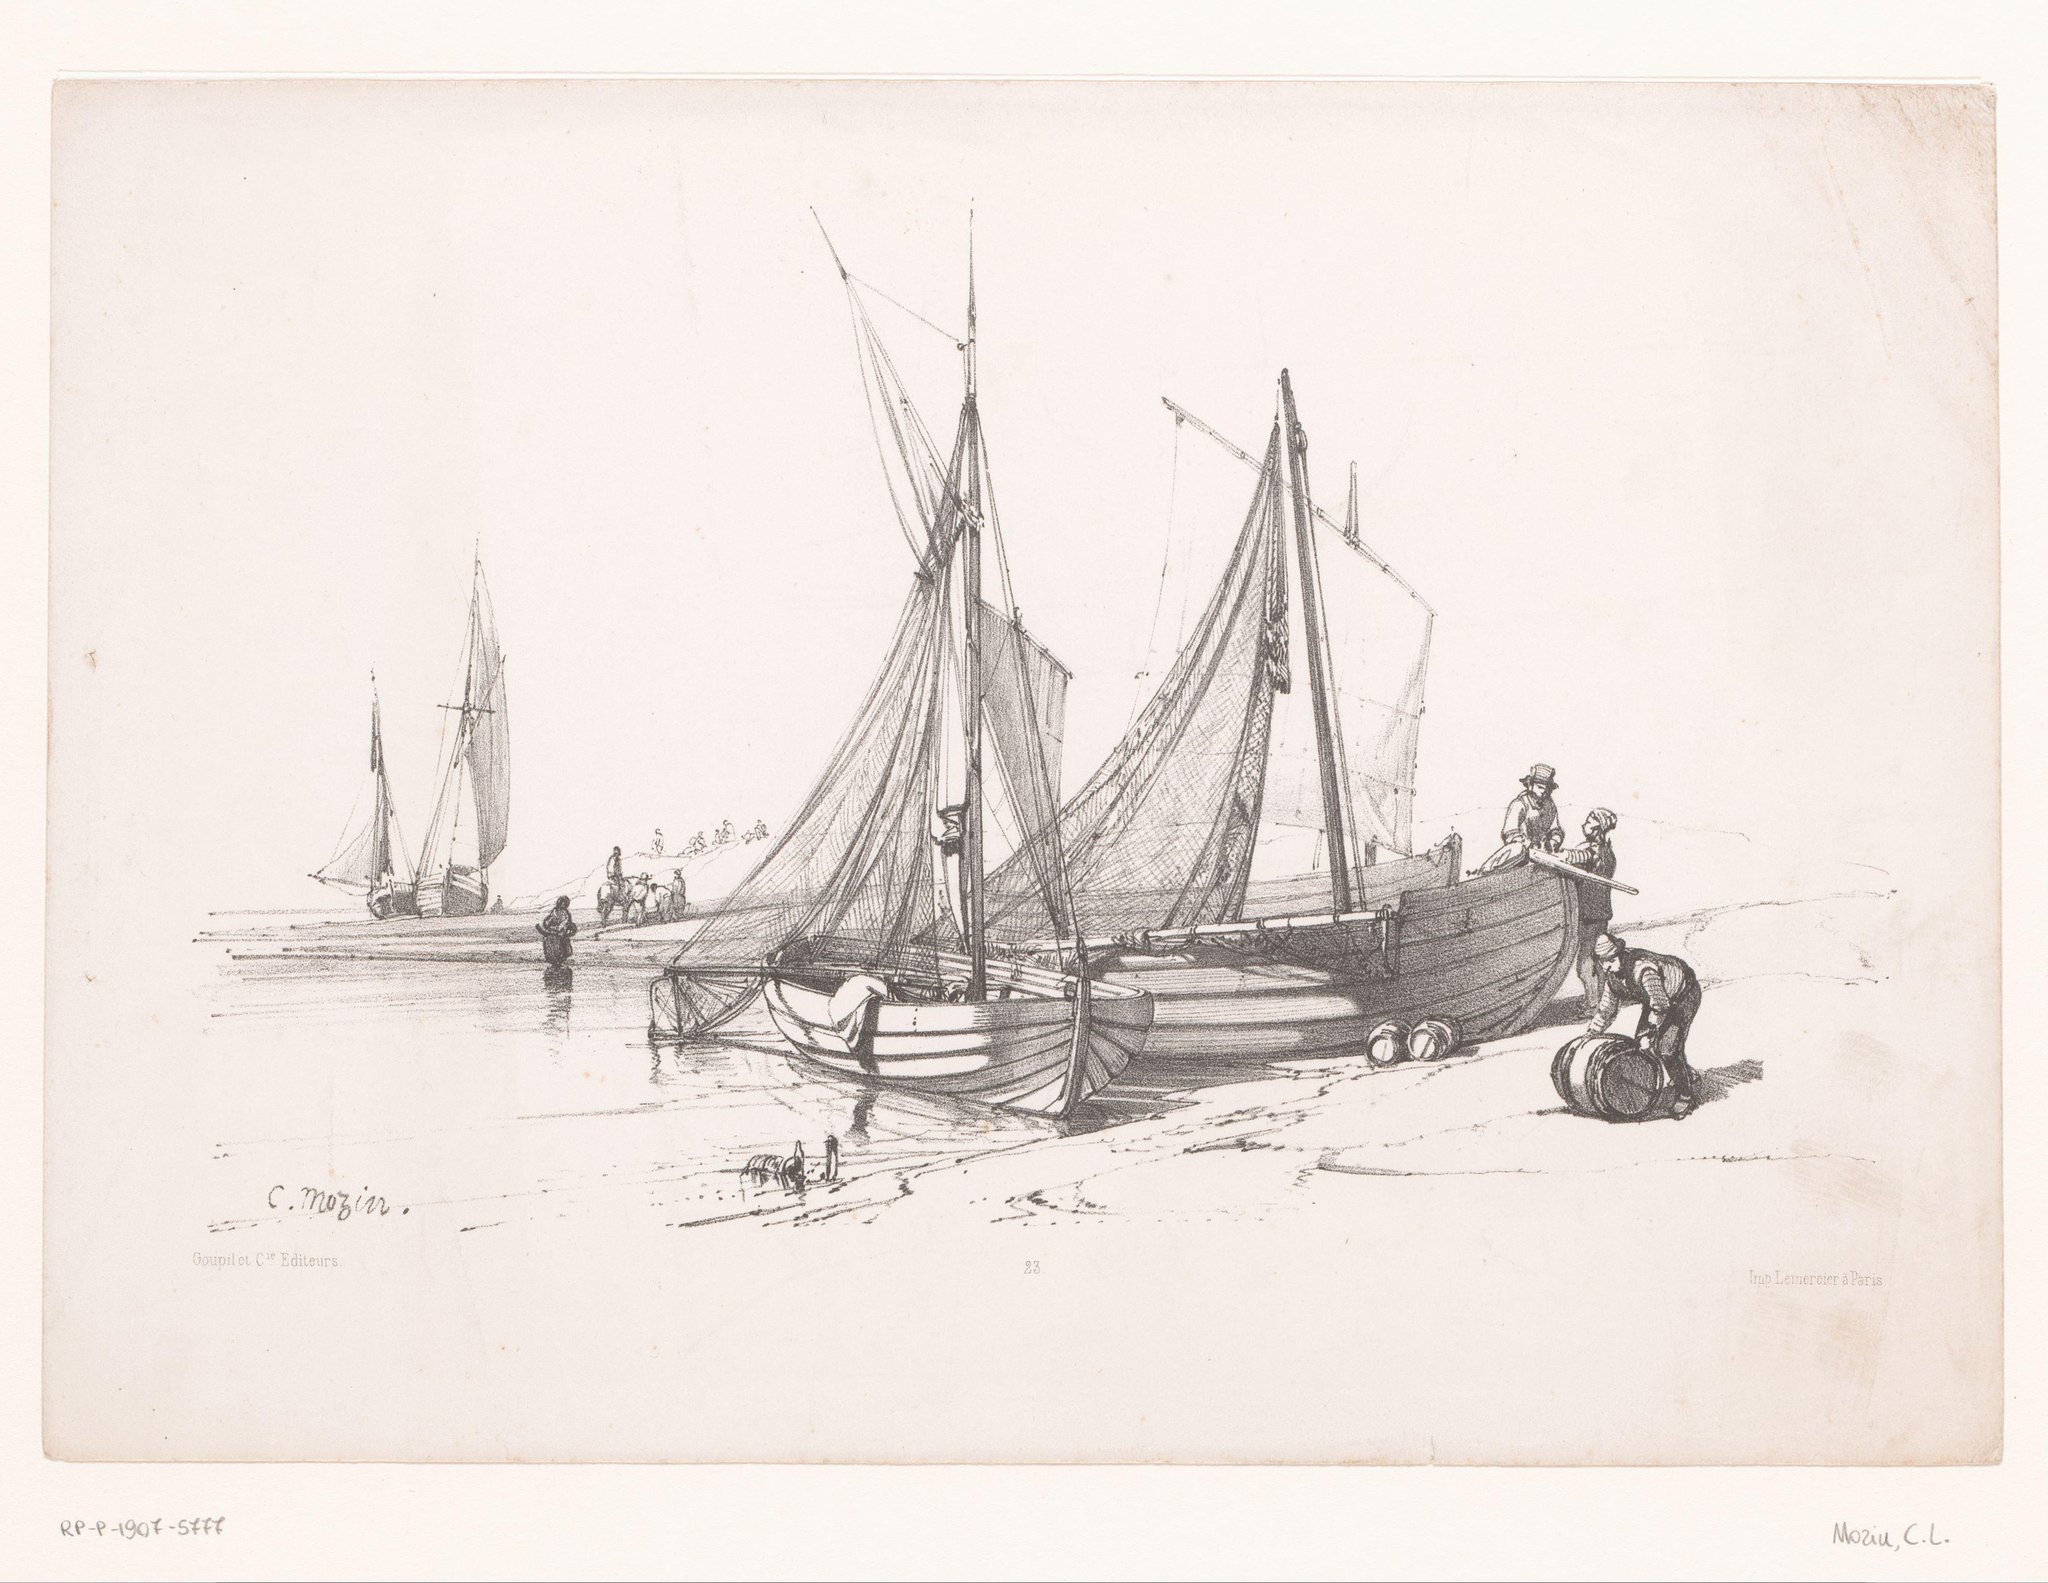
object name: print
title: Zeilschepen op het strand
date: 1850-1884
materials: paper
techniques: lithograph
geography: paris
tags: wooden container: barrel, cask, bucket, sailing-ship, sailing-boat, beach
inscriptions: collector's mark: Lugt 2228